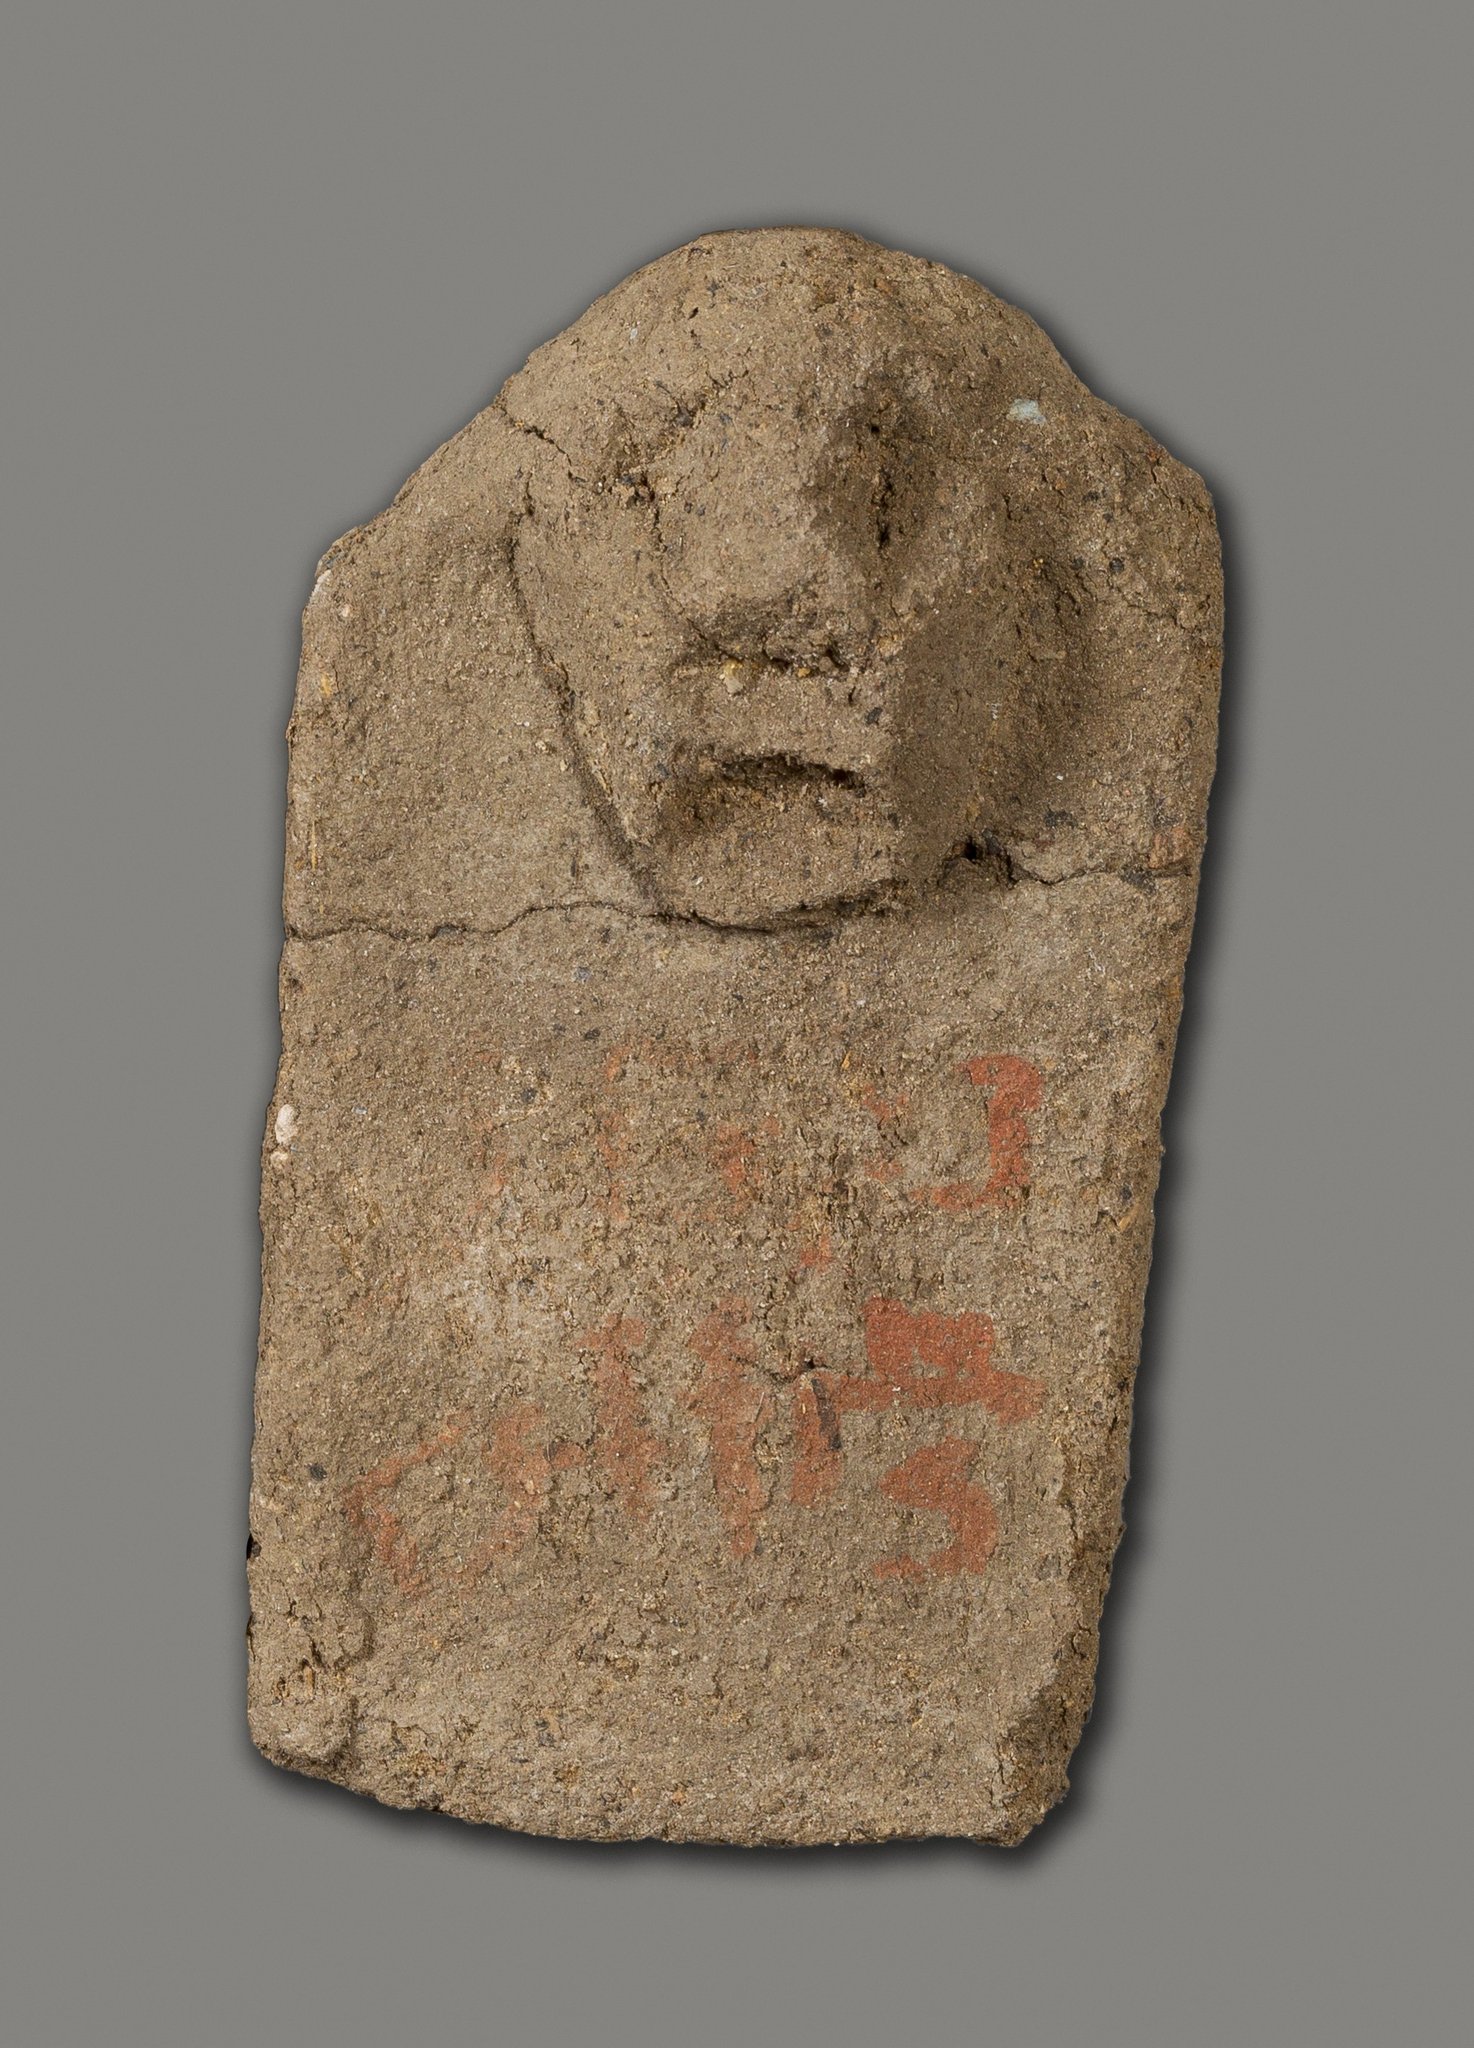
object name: figure, magical, execration, tablet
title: Magical Figure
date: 1802-1550 BCE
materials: clay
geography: egypt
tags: faces